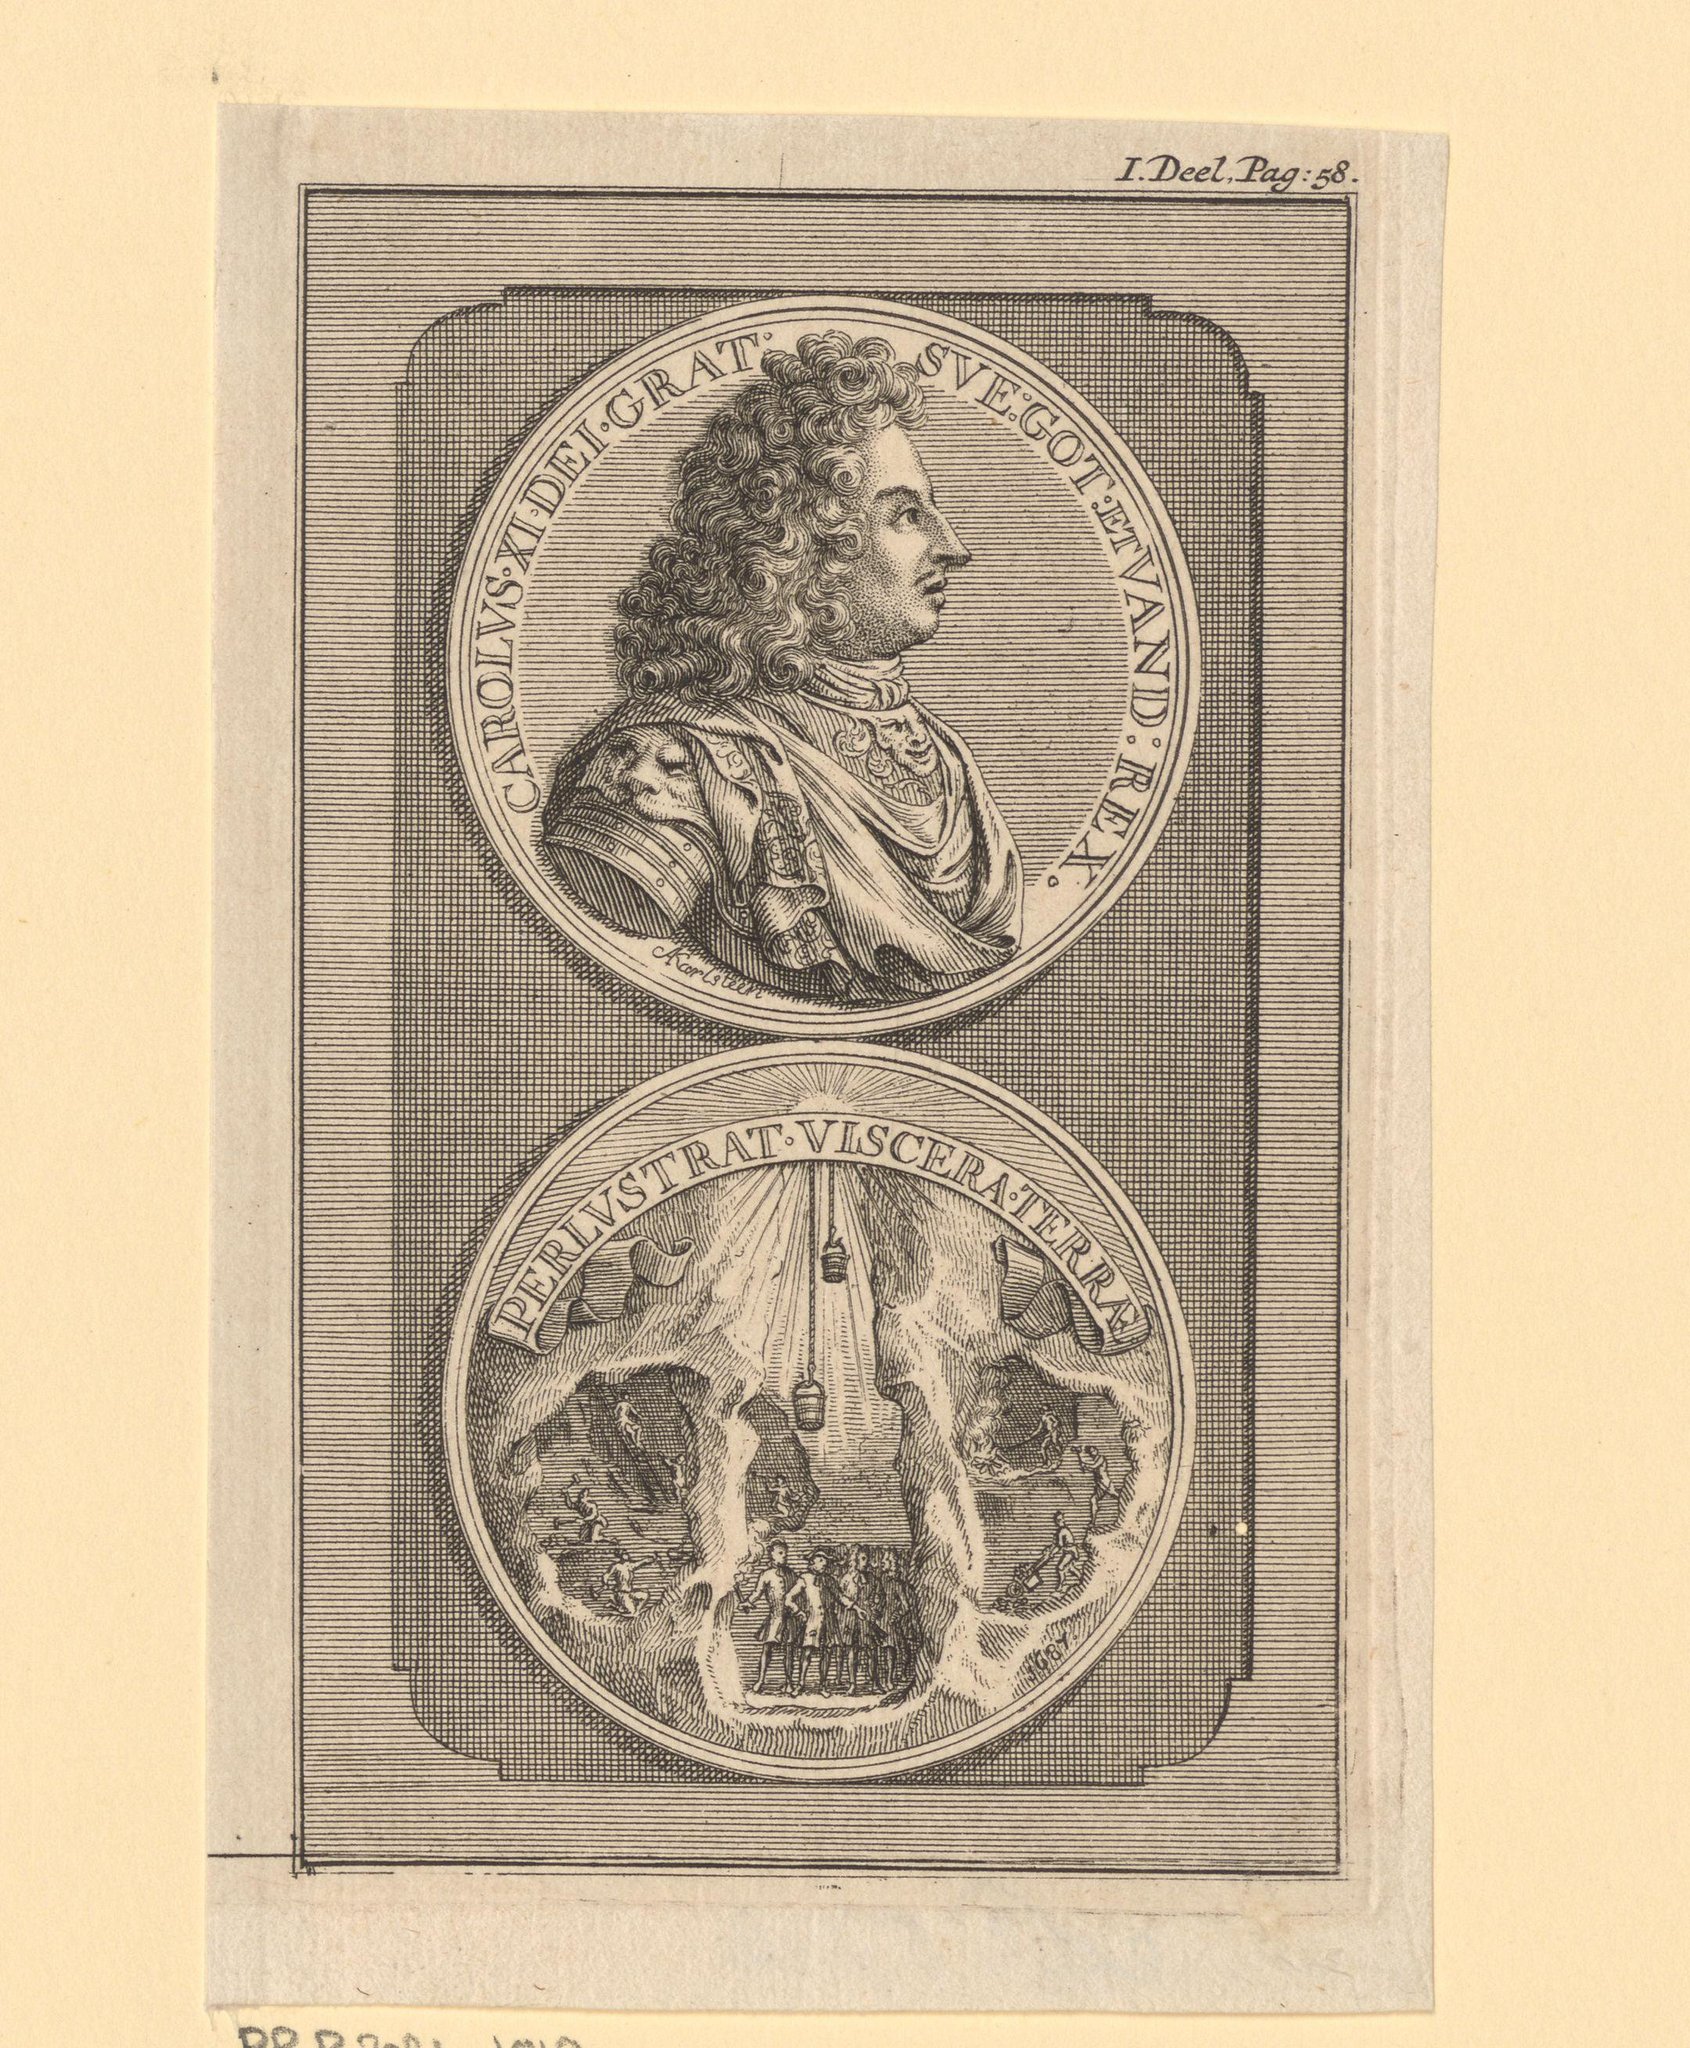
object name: print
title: Medaille met het portret van Karel XI, koning van Zweden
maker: Anonymous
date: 1680-1749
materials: paper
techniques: etching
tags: historical persons, memorial medal, king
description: Rechtsboven genummerd: I. Deel. Pag: 58.